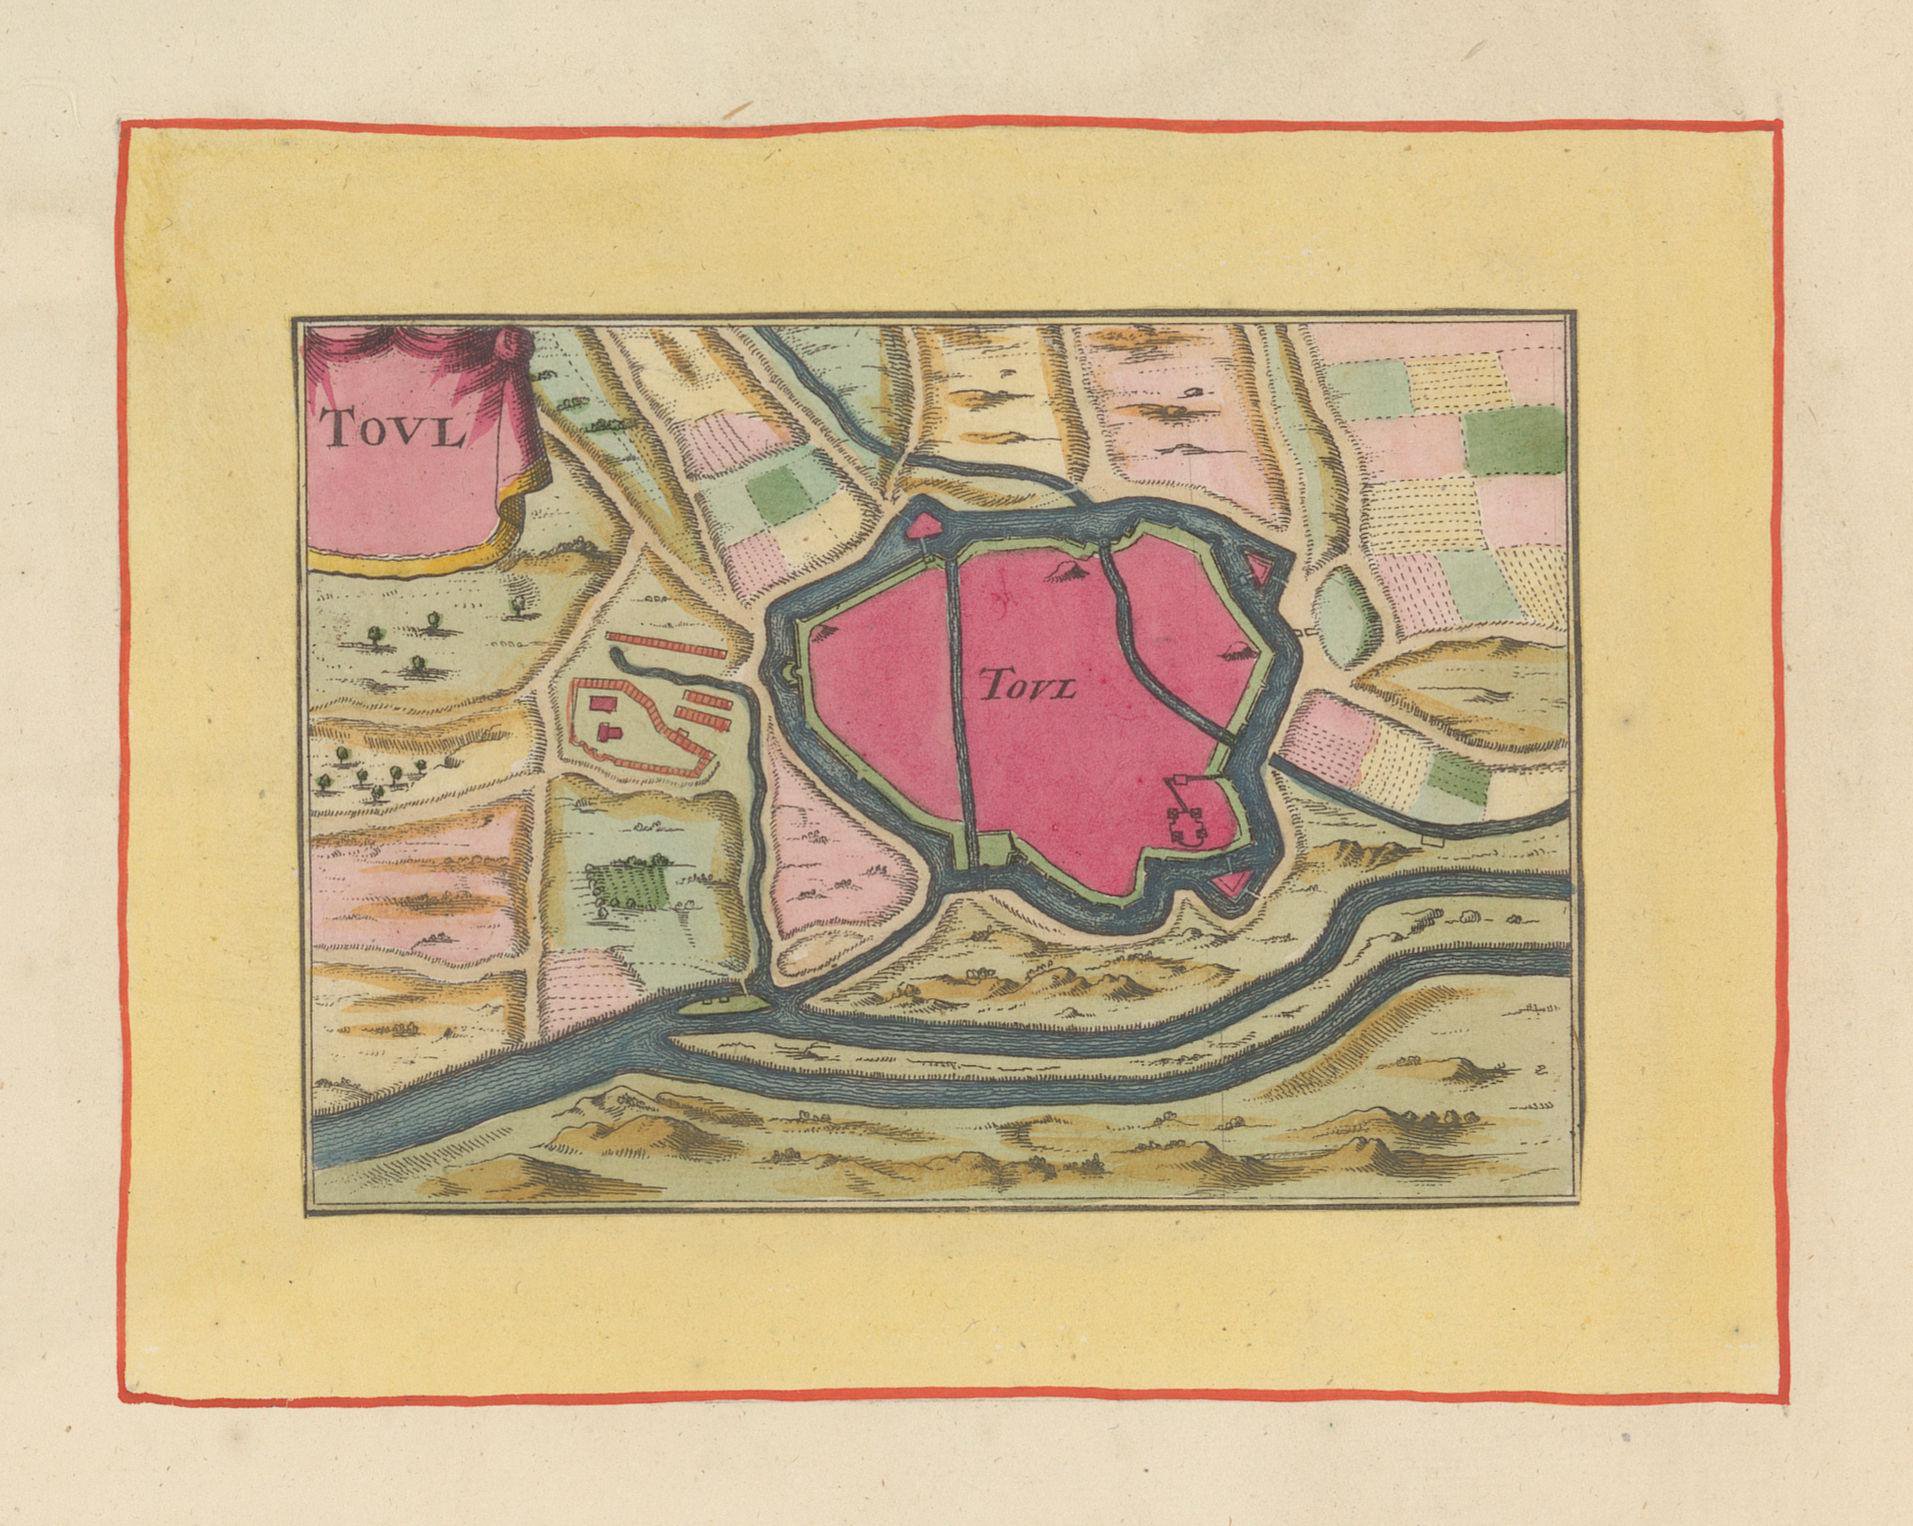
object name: album leaf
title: Toul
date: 1638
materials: paper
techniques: engraving, hand coloring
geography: the hague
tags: maps of cities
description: Prent uit: Tassin, Christophe. Les plans et profils de toutes les principales villes et lieux considérables de France (...). Parijs: Michel van Lochom, 1638, plattegrond nummer 10 in het deel 'Lorraine'.